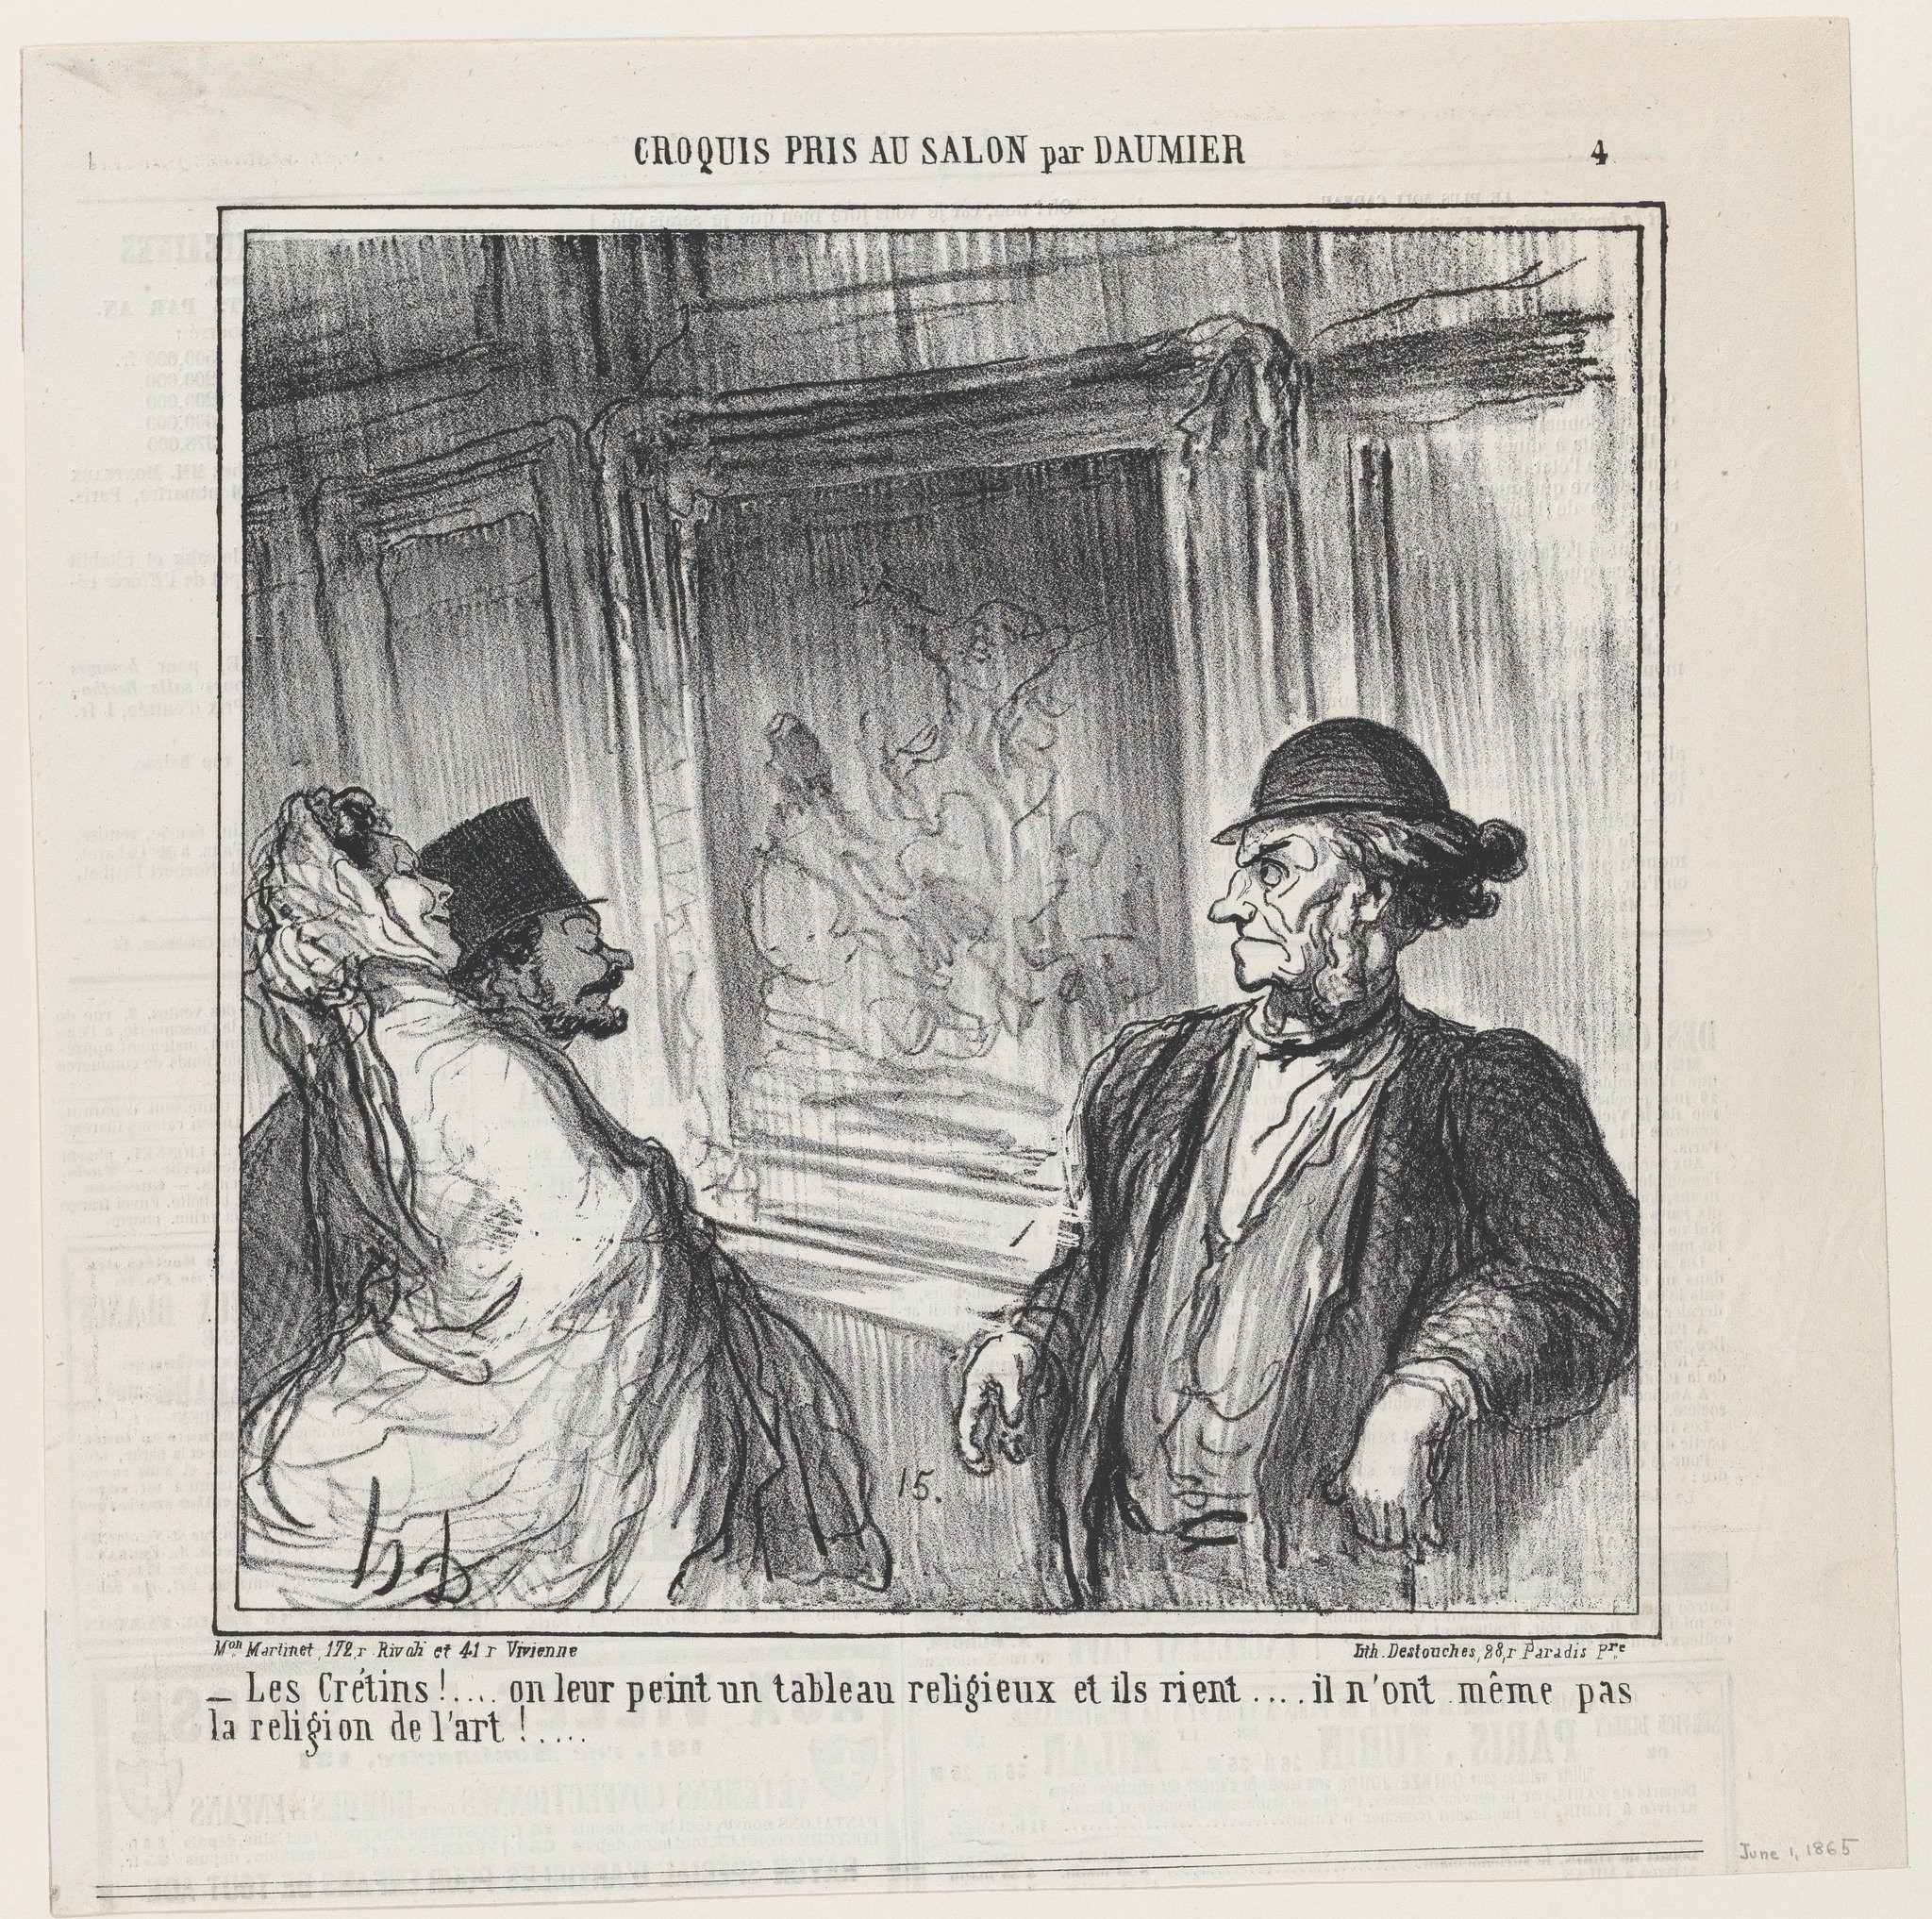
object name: print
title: What idiots! You paint a religious picture for them and they laugh.... they don't even have a devotion to art!..., from 'Sketches from the Salon,' published in Le Charivari, June 1, 1865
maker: honoré daumier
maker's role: artist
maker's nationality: french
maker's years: 1808-1879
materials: paper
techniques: lithograph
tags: satire,men,women